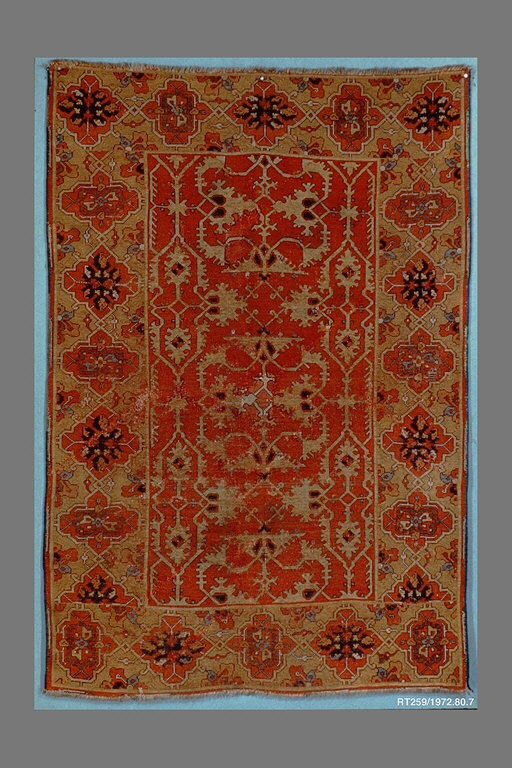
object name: carpet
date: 1601-1700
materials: wool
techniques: pile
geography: turkey